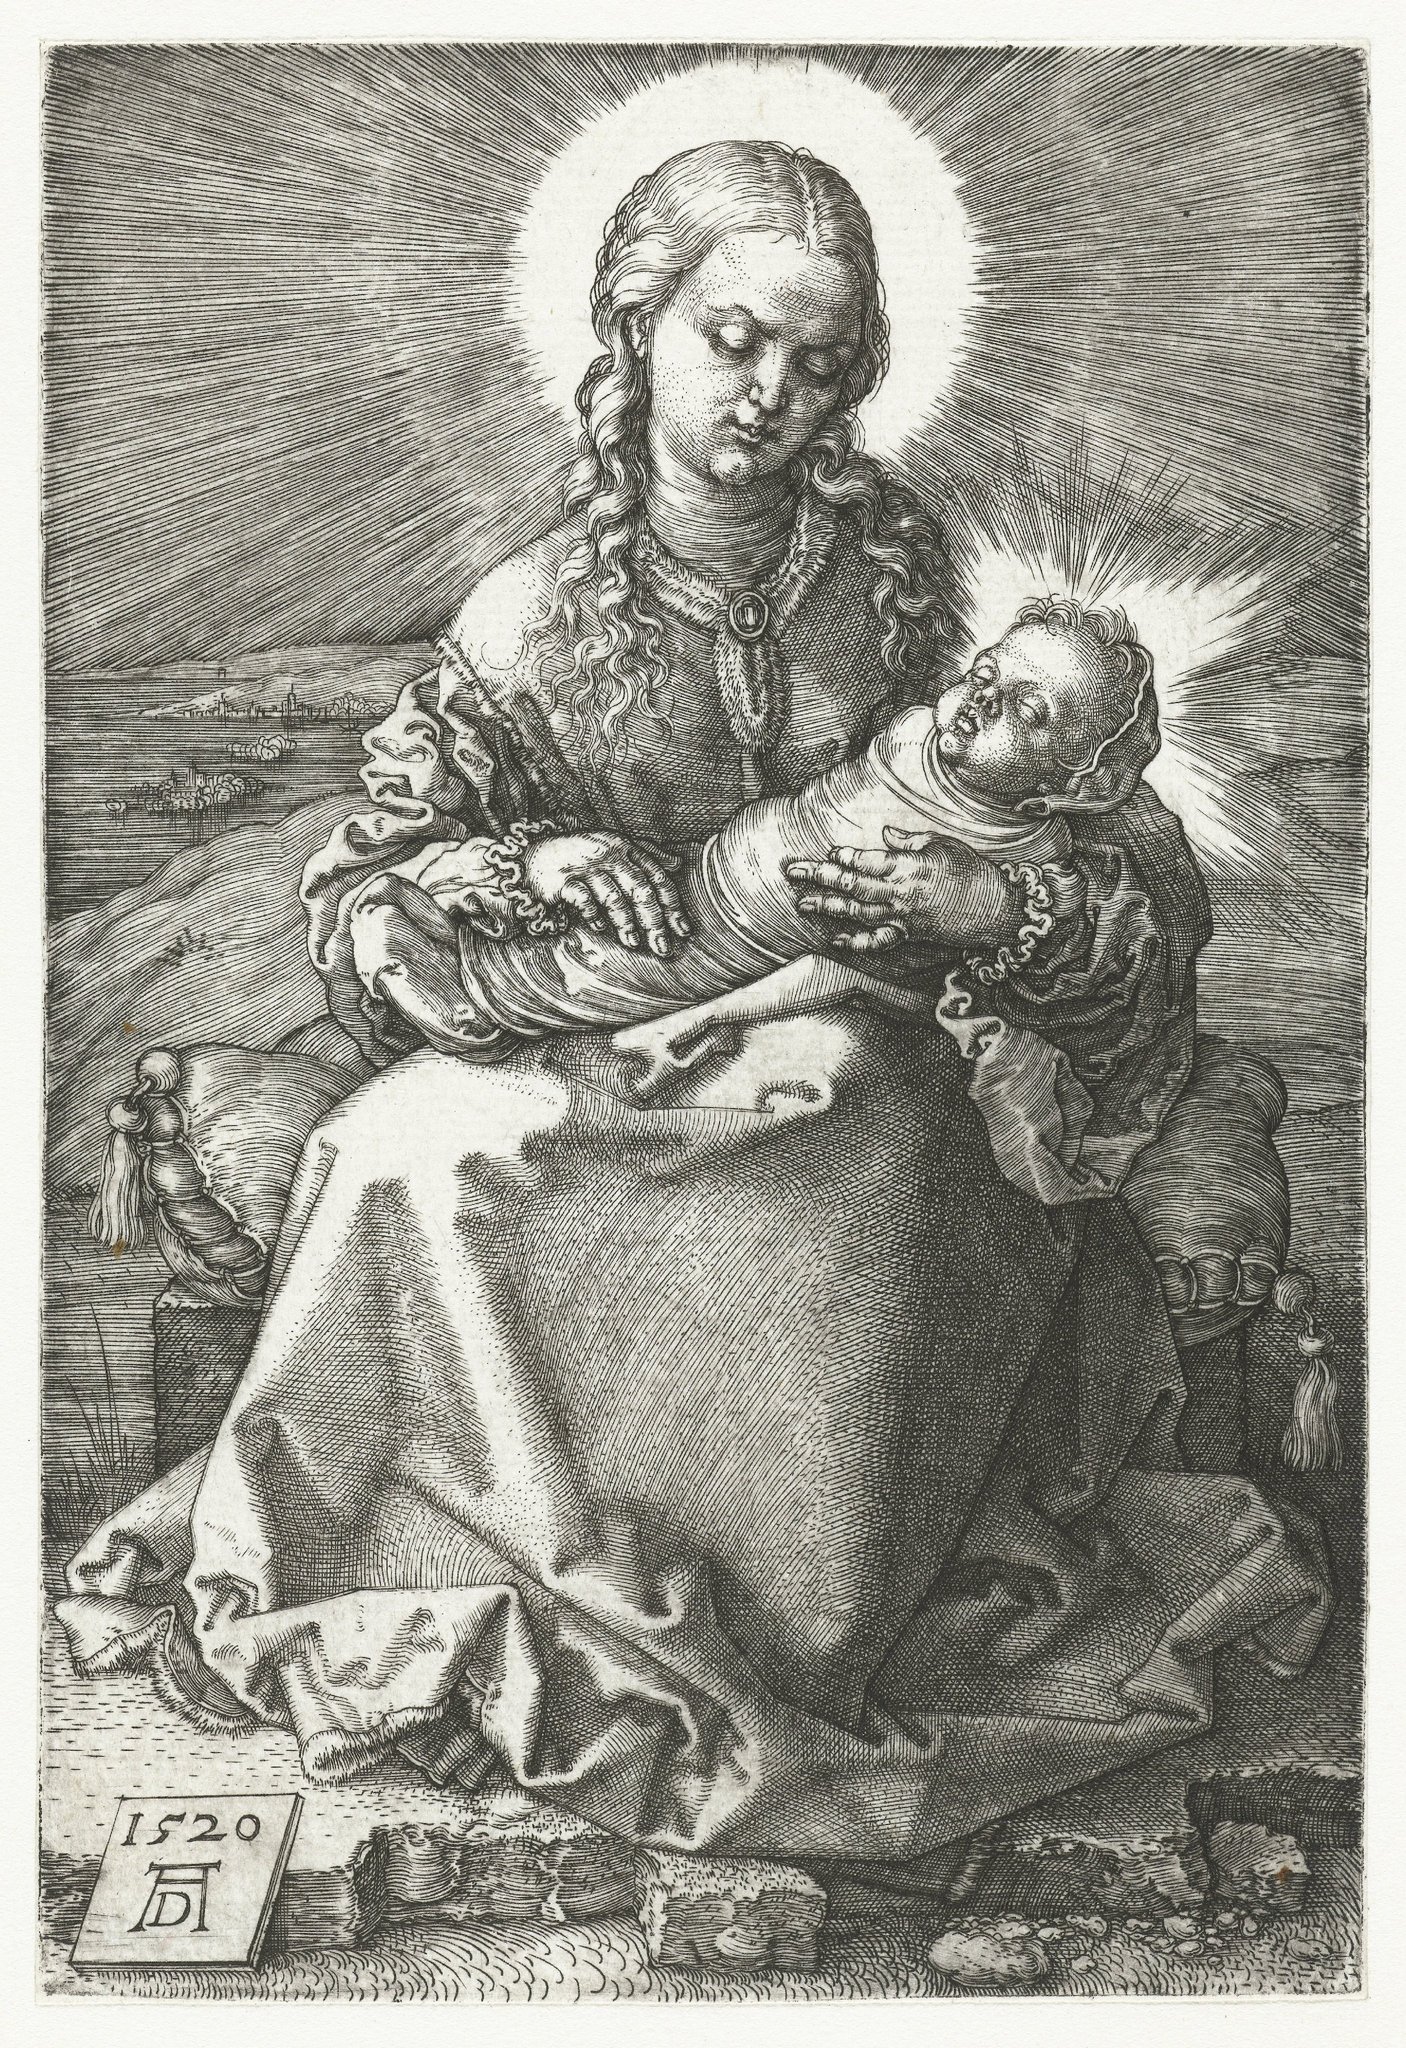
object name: print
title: Maria met ingebakerd kind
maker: albrecht dürer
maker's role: draughtsman, painter, print maker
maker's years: 1471-1528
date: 1520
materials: paper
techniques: engraving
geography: nuremberg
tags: mary sitting or enthroned, the christ-child in front of her, lying in her lap (or in front of her bosom), sometimes in pietà-posture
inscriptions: collector's mark: Lugt 2228a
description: Mogelijk had deze prent oorspronkelijk het inventarisnummer RP-P-1877-A-33 (zie opmerking aldaar). Klinkert, C.